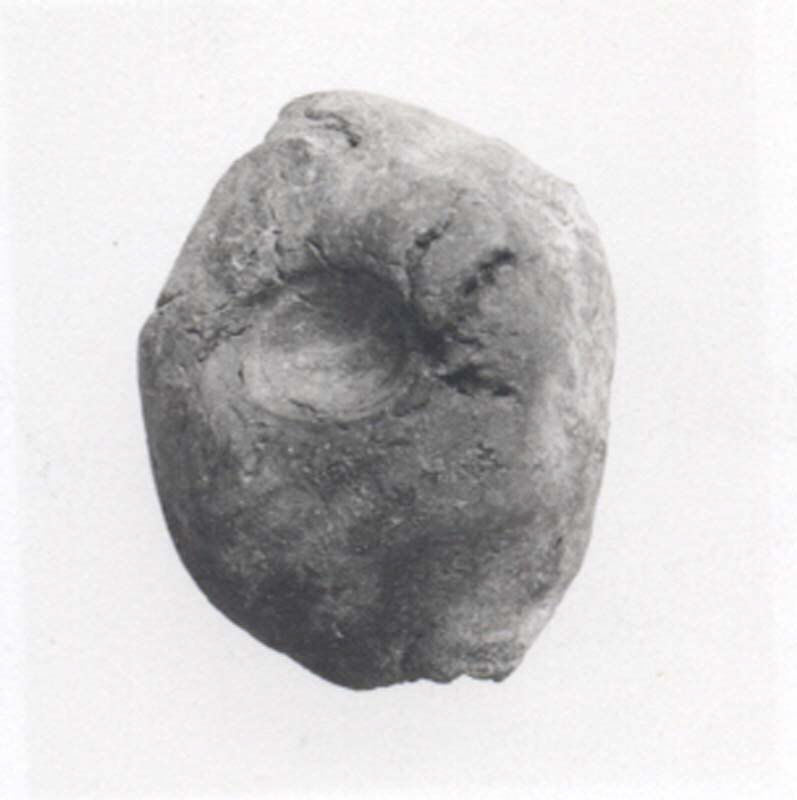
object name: sealing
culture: sasanian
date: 601-700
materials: clay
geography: iran